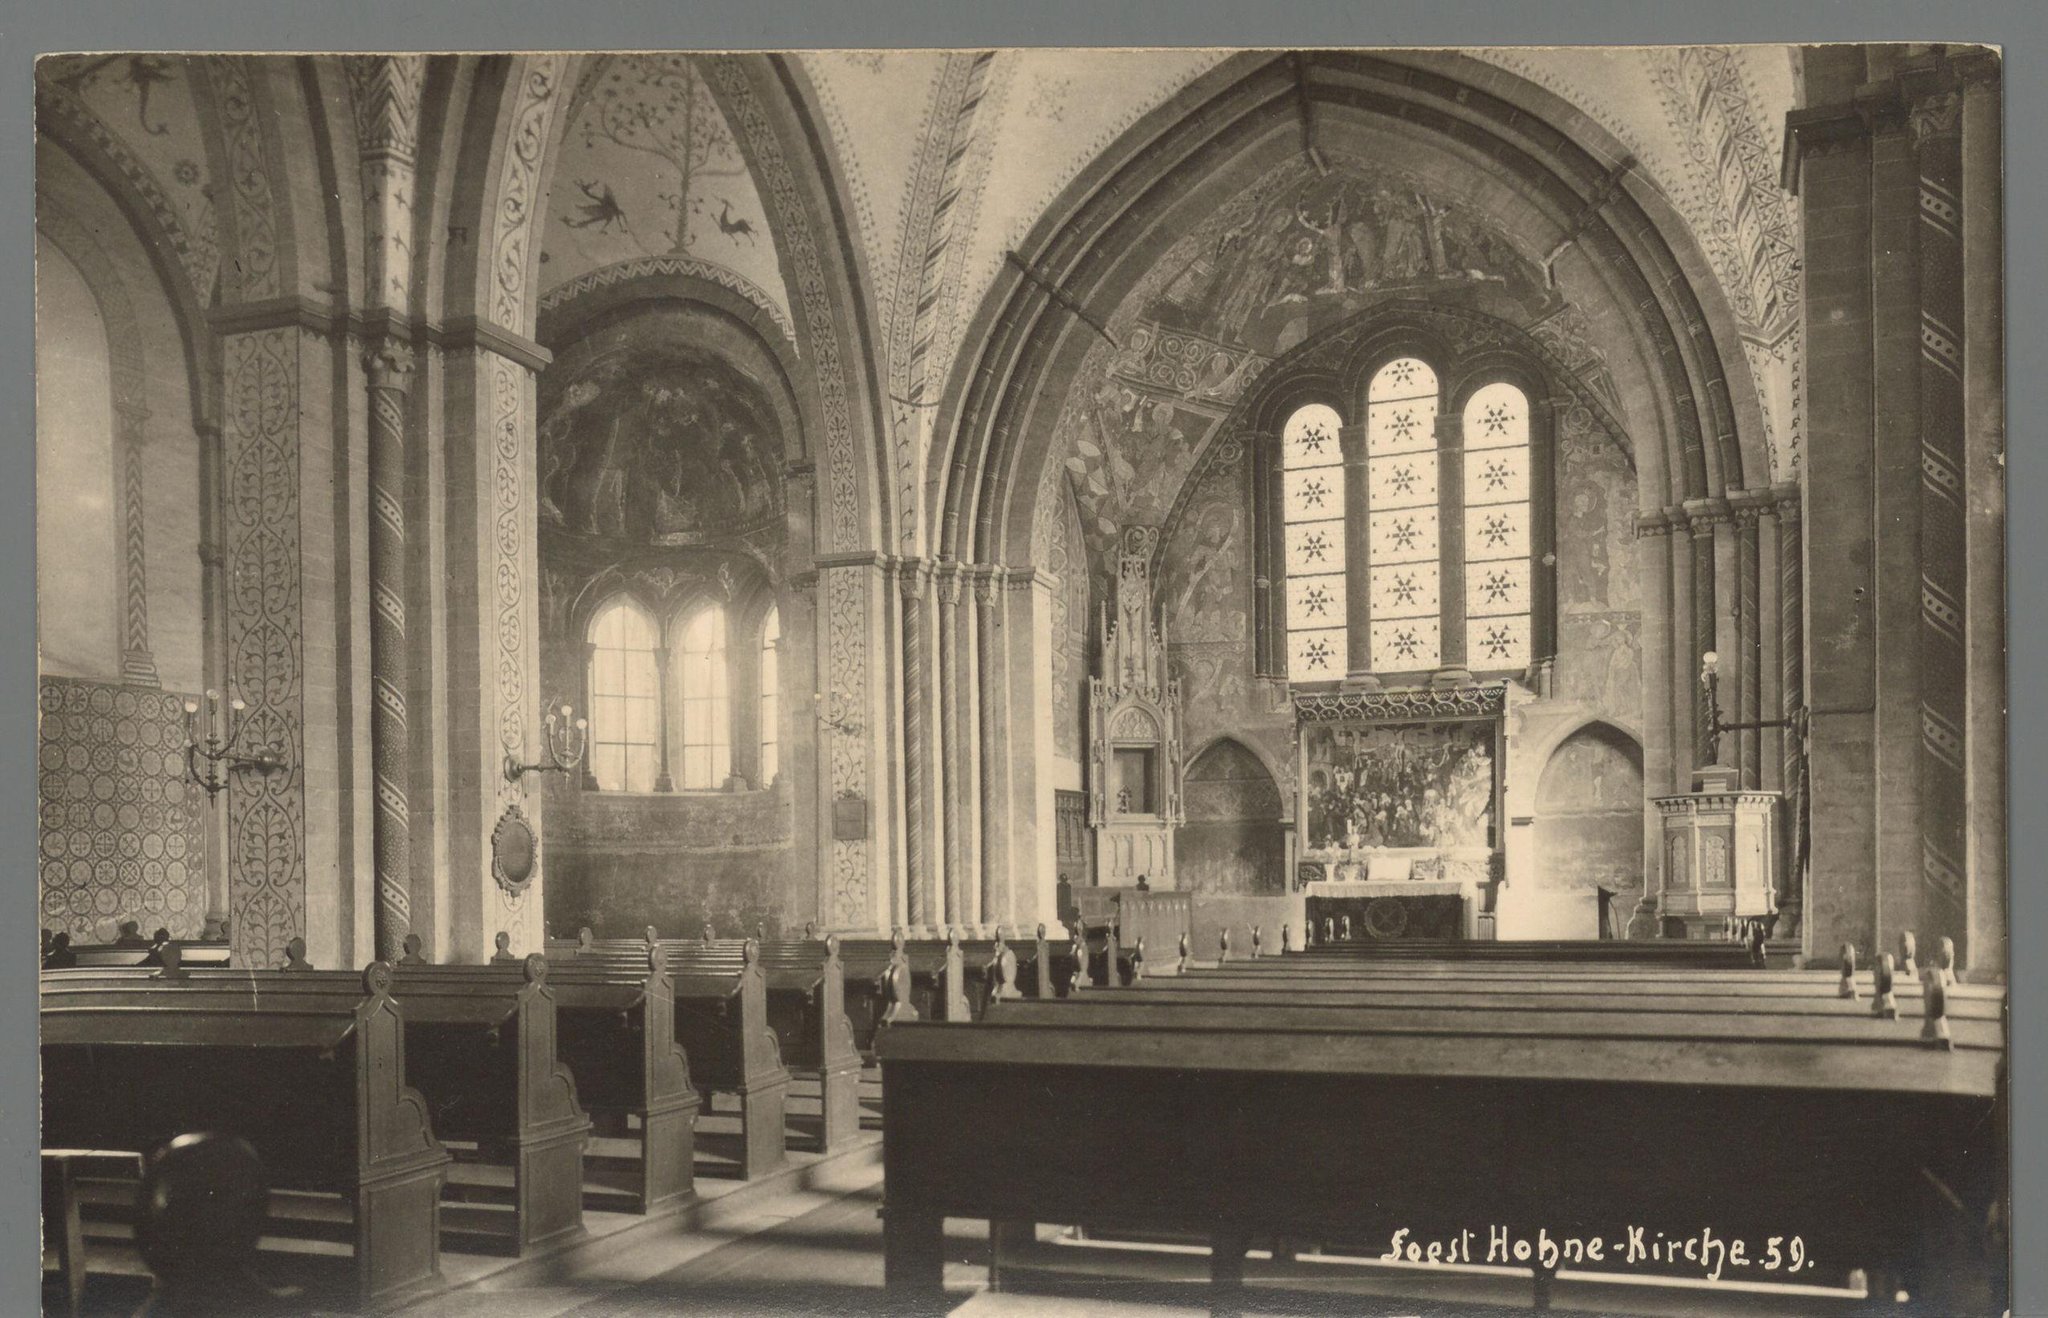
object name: ansichtkaart, prentbriefkaart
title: Soest. Hohne-Kirche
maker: w. lange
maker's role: fotograaf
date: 1905-1930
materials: photographic support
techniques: gelatin silver print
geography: soest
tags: interior of church